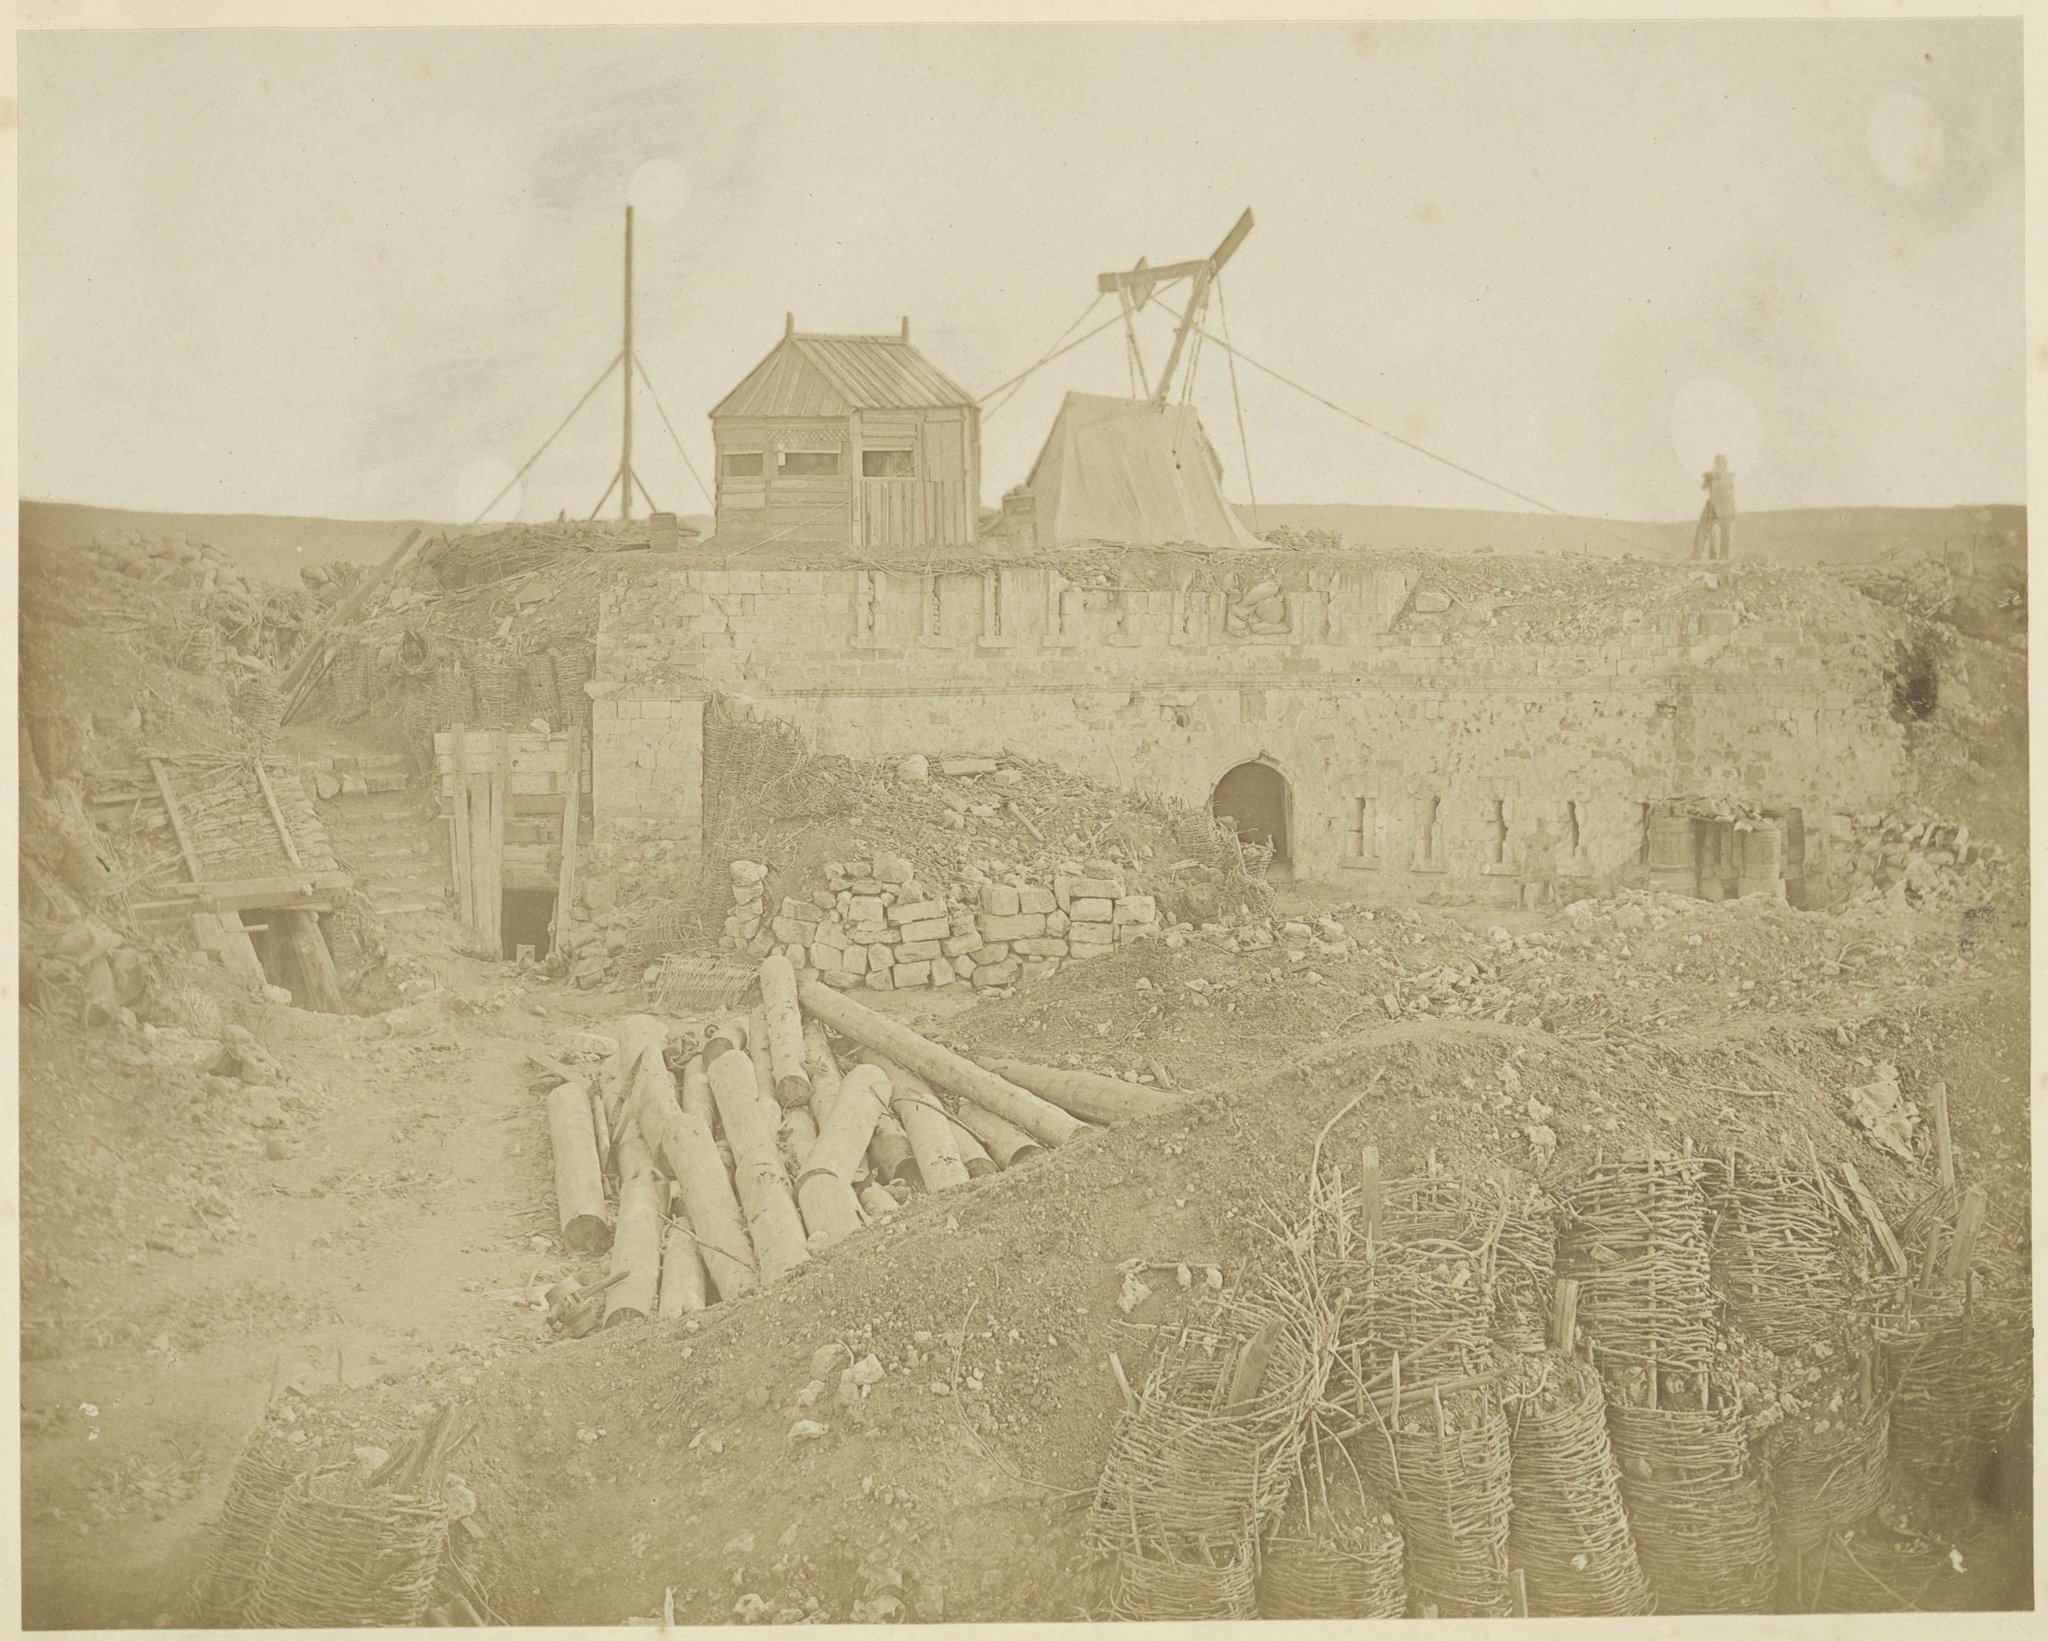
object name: photograph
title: Family Photographs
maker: james robertson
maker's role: fotograaf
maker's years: 1813-1888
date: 1855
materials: cardboard, photographic support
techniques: salted paper print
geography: crimea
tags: fortress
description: The hustle and bustle of a family with young children: intimate images of daily life one hundred years ago taken just around the corner of the museum, near the Vondelpark. Teding van Berkhout, who knew everything about 17th-century drawings and worked in the Rijksmuseum, lived there. He would have been so surprised to see private photographs hanging on the wall here, and ones taken by himself no less.